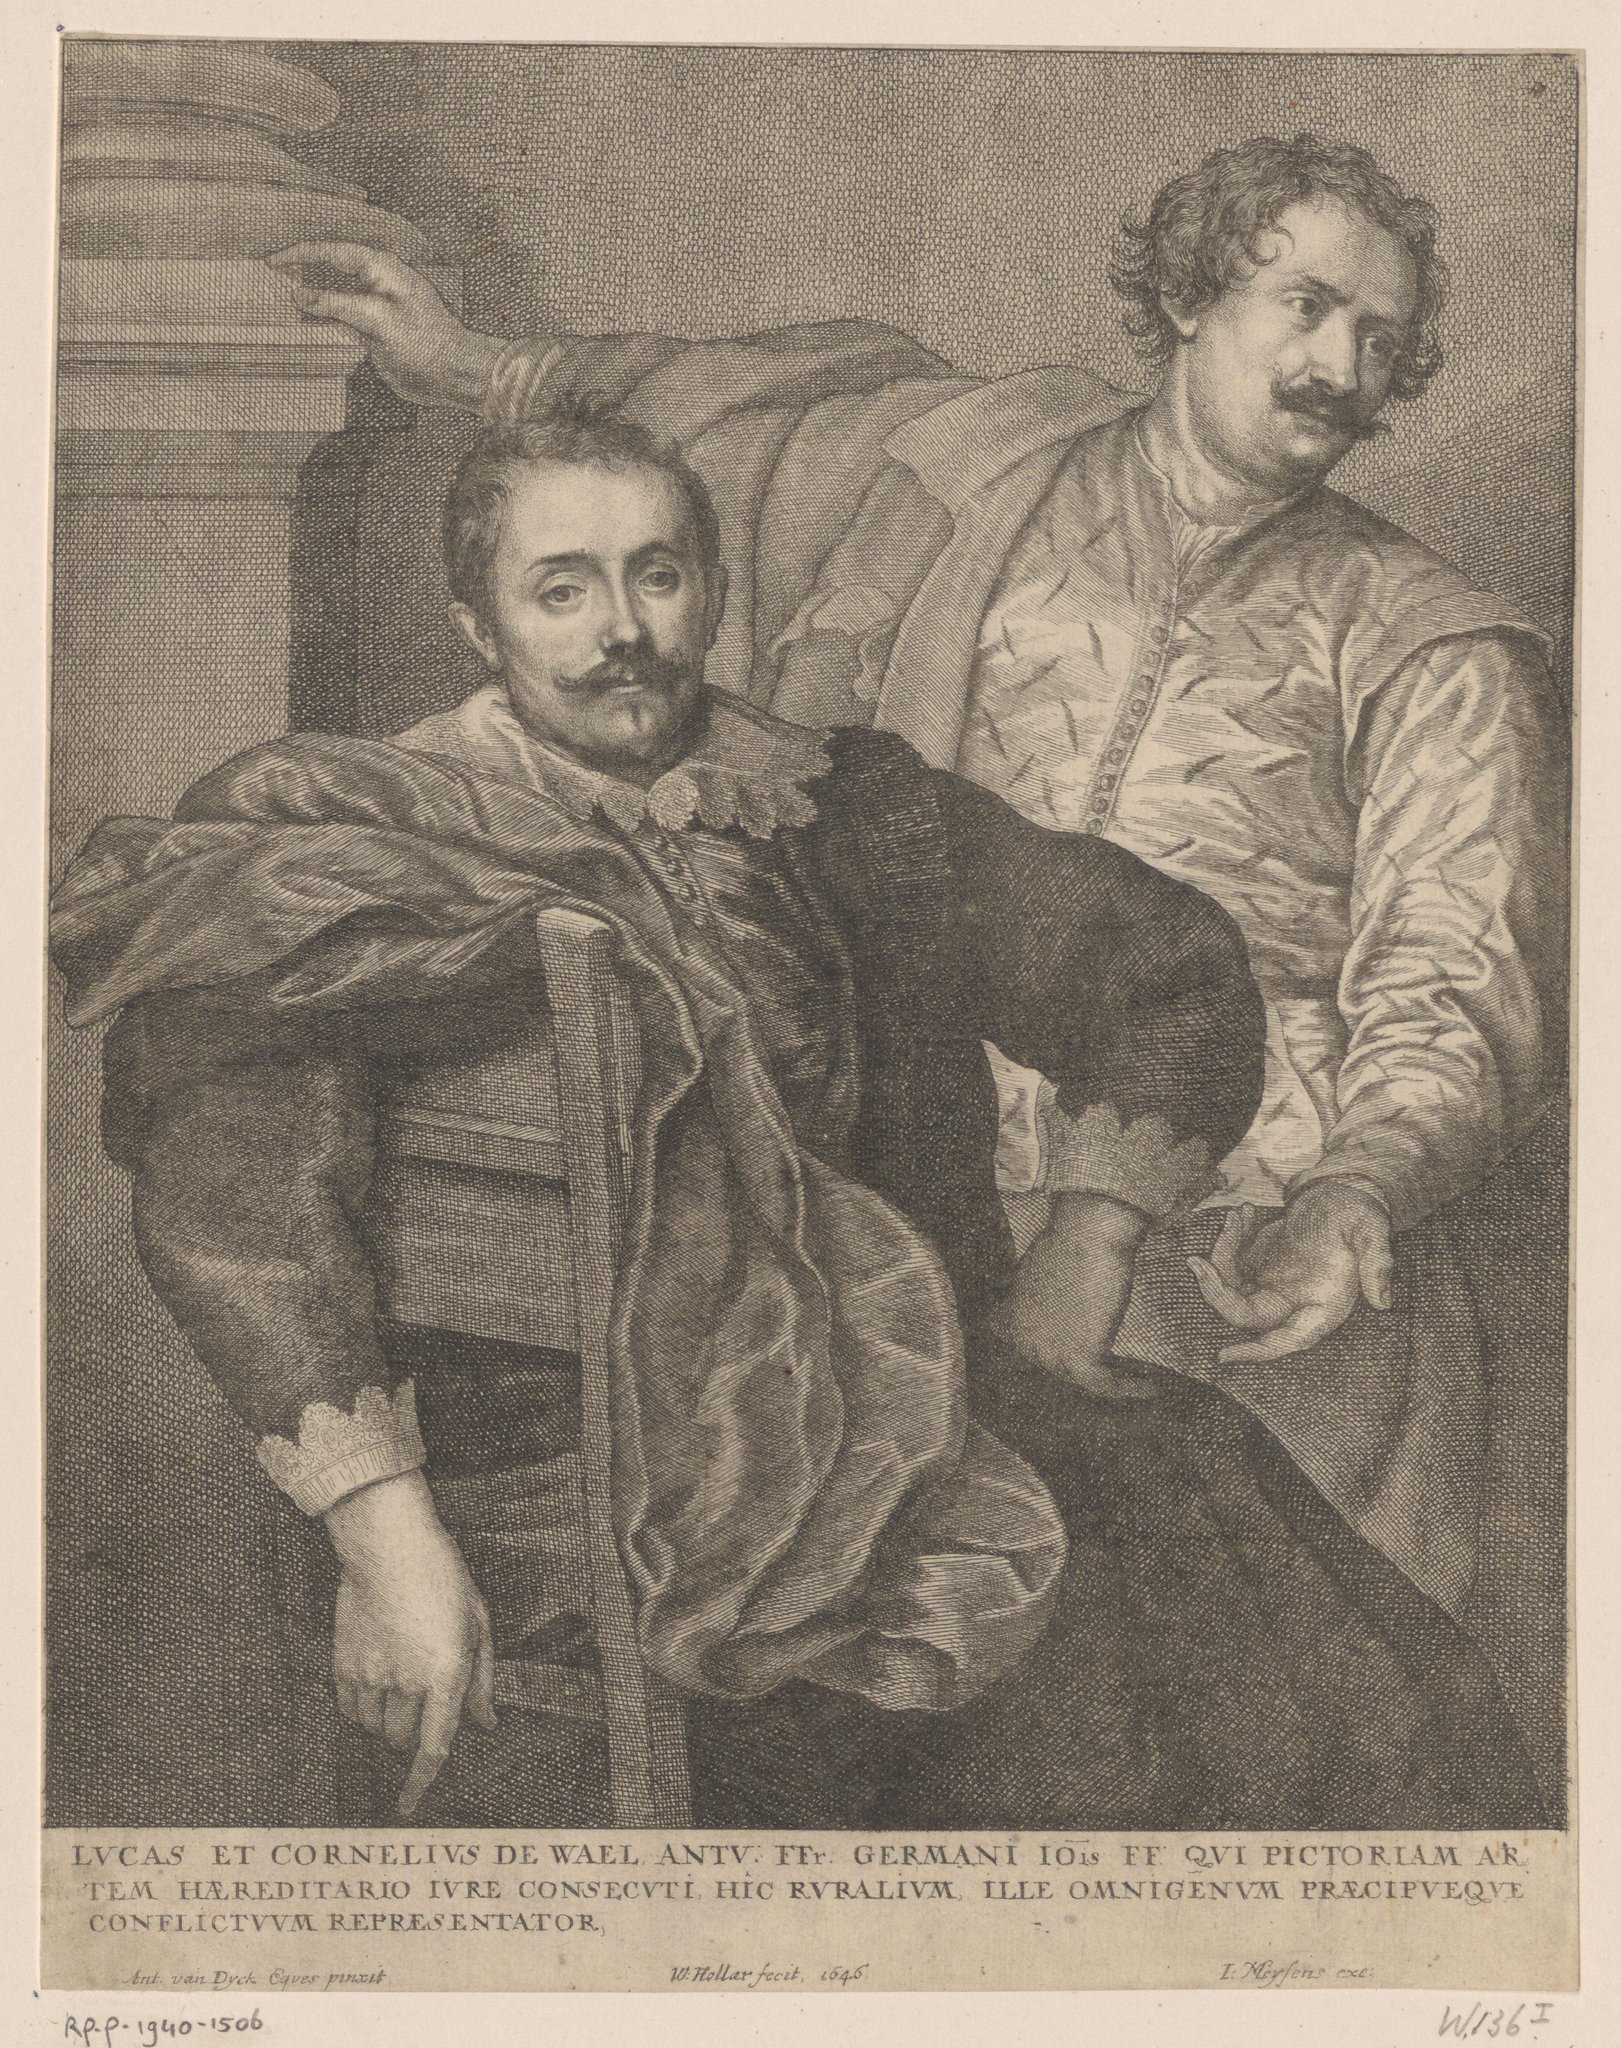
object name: print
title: Portret van Lucas de Wael en Cornelis de Wael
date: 1646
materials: paper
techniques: etching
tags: rome, print maker, draughtsman, cornelis de wael, antwerp, painter, historical persons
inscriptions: watermark:, collector's mark: Lugt 2228, collector's mark: Lugt 2760, collector's mark: Lugt 2166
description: De prent maakt deel uit van een zevendelige serie portretten naar Anthony van Dyck, uitgegeven door Joannes Meyssens.